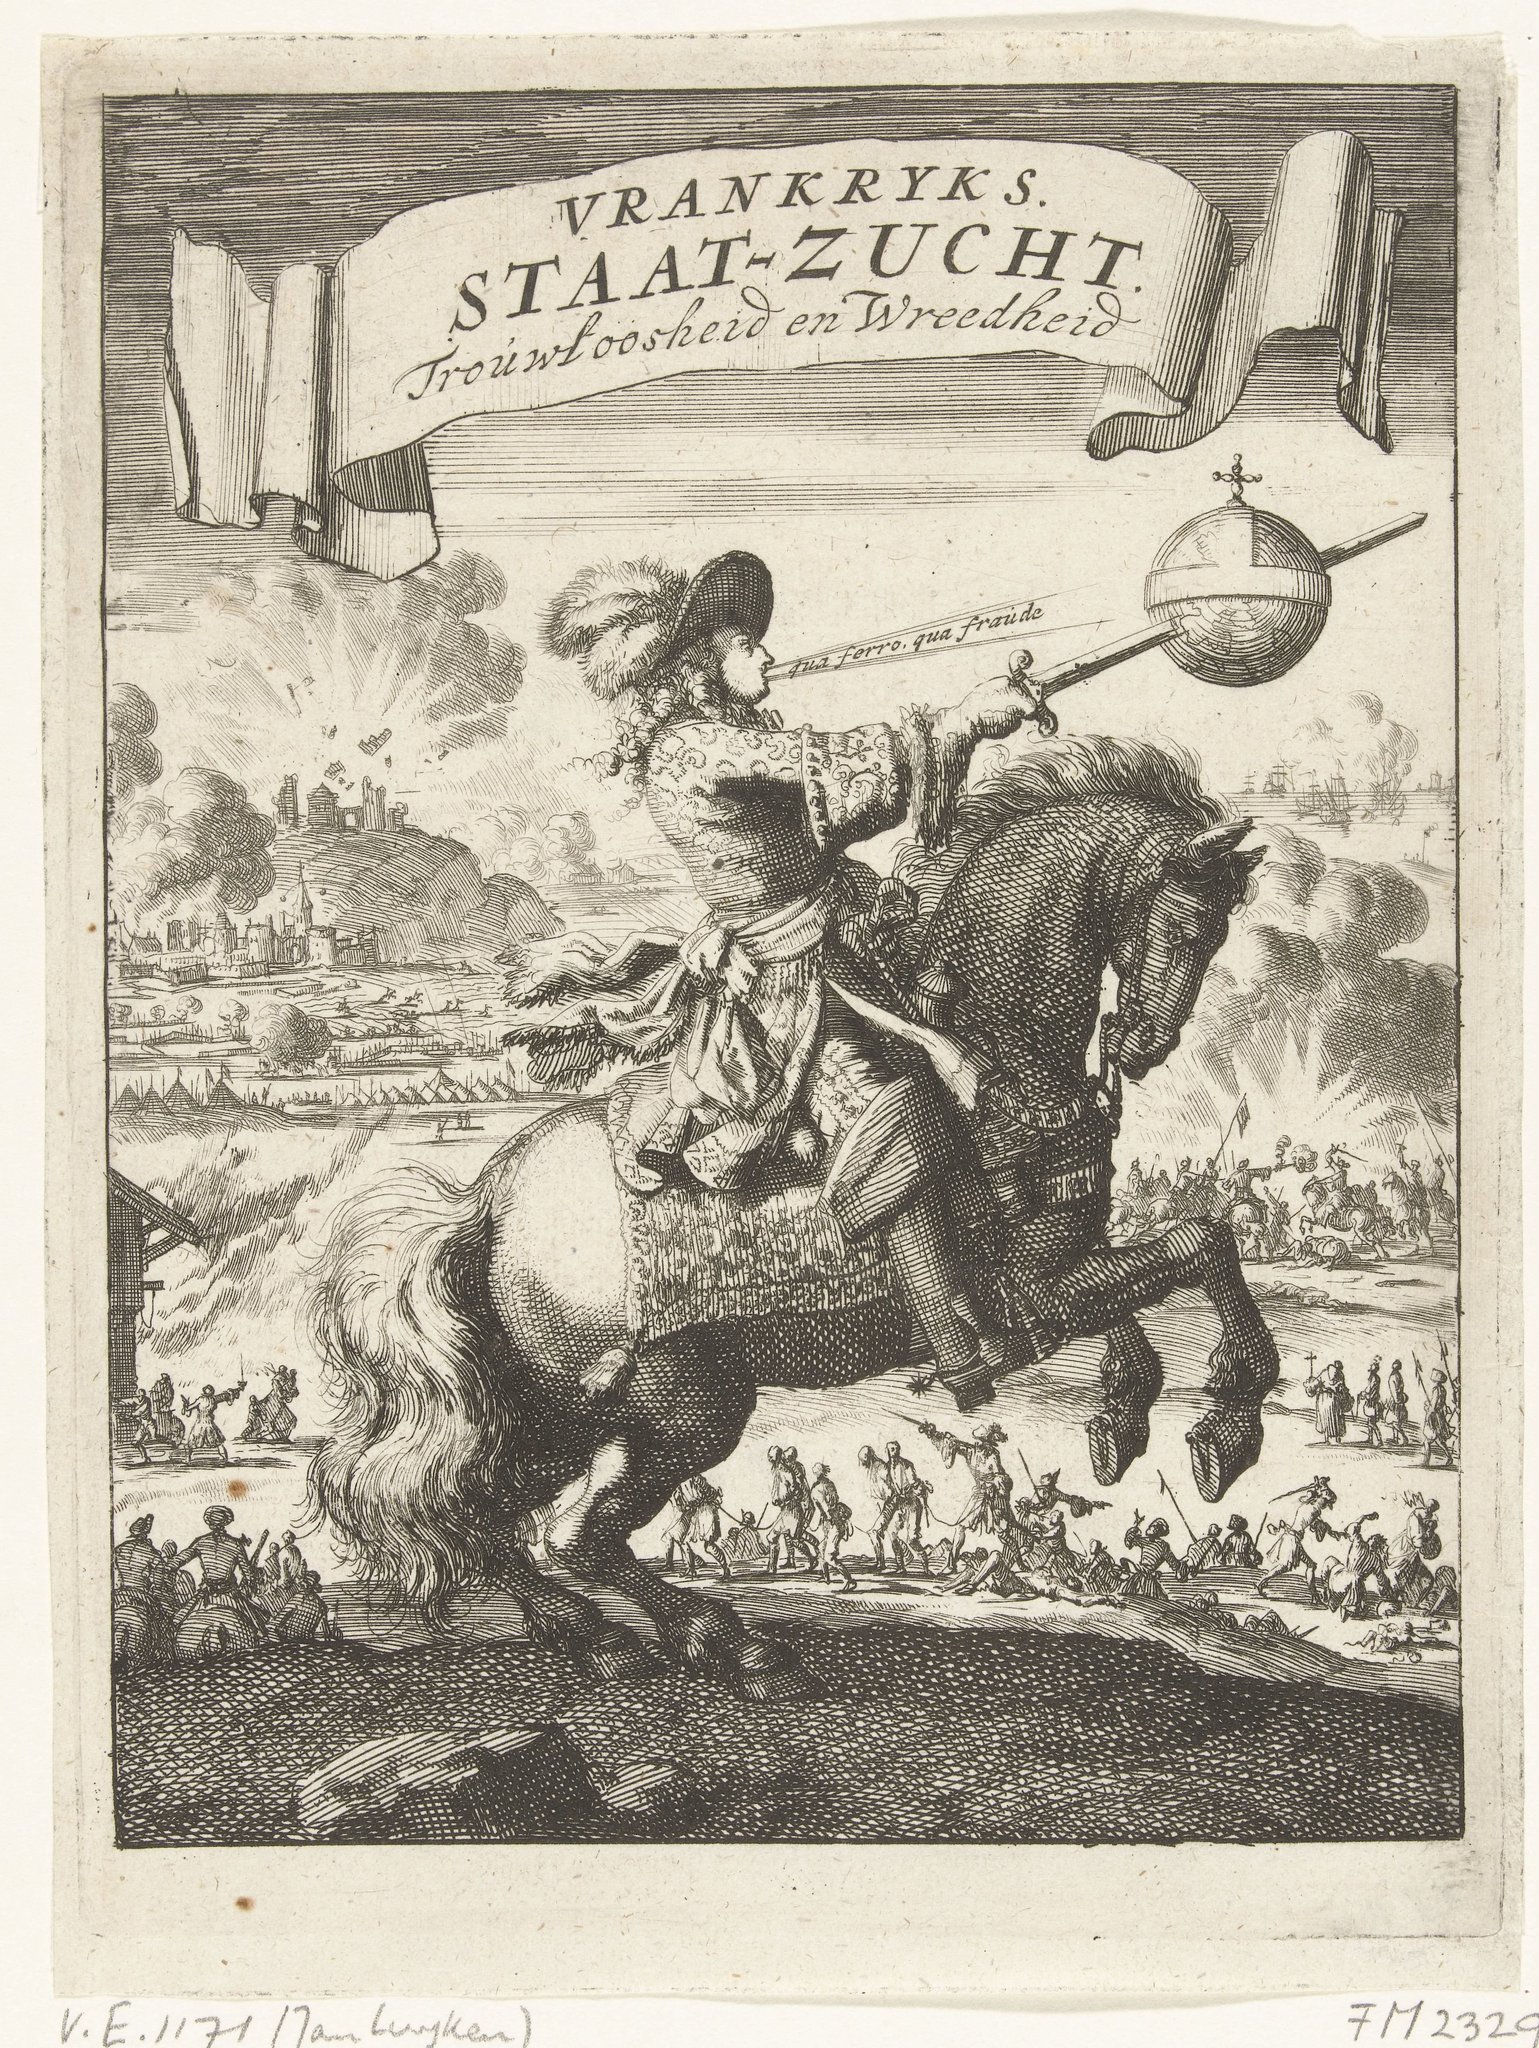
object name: print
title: Titelpagina van: Vrankryks Staat-zucht. Trouwloosheid en Wreedheid, 1690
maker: jan luyken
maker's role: draughtsman, print maker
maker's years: 1649-1712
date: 1688-1690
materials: paper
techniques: engraving, etching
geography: northern netherlands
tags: lodewijk xiv (koning van frankrijk)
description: Gebruikt als gegraveerde titelpagina voor het pamflet: Vrankryks staat-zucht, trouwloosheid en wreedheid, ten toon gesteld in de onrechtvaardige pretentien en schrikkelijke bedrijven van Lodewijk de XIV, C. Teydema, Leeuwarden en Jan Claesz ten Hoorn, Amsterdam, 1690. Het pamflet zelf (zonder titelpagina) ook in de collectie in map MI-P-FM-PAMF-MAP-1304/2943.